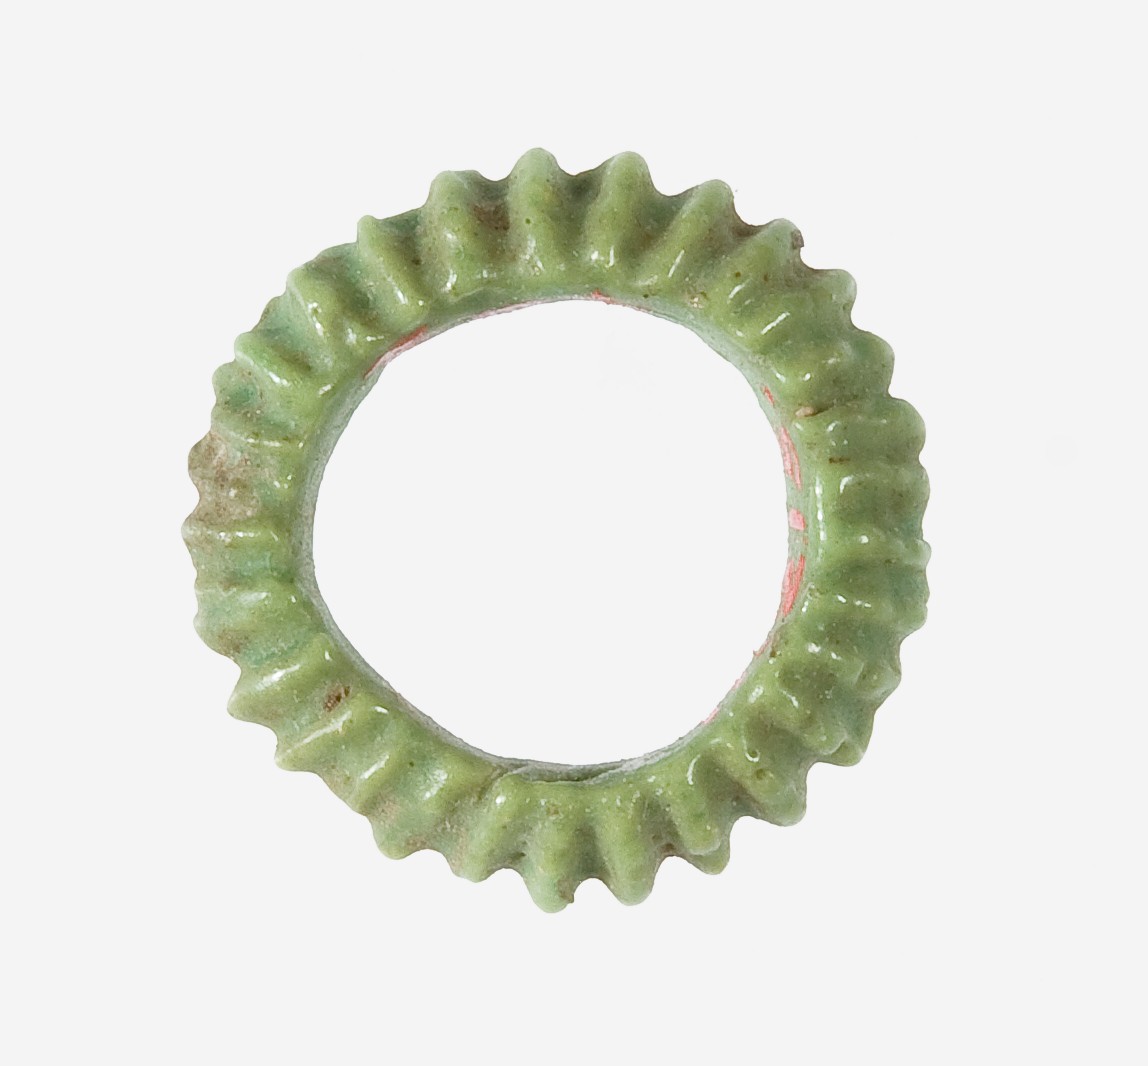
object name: pendant, ring shaped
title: Ring Pendant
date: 1390-1352 BCE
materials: faience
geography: egypt